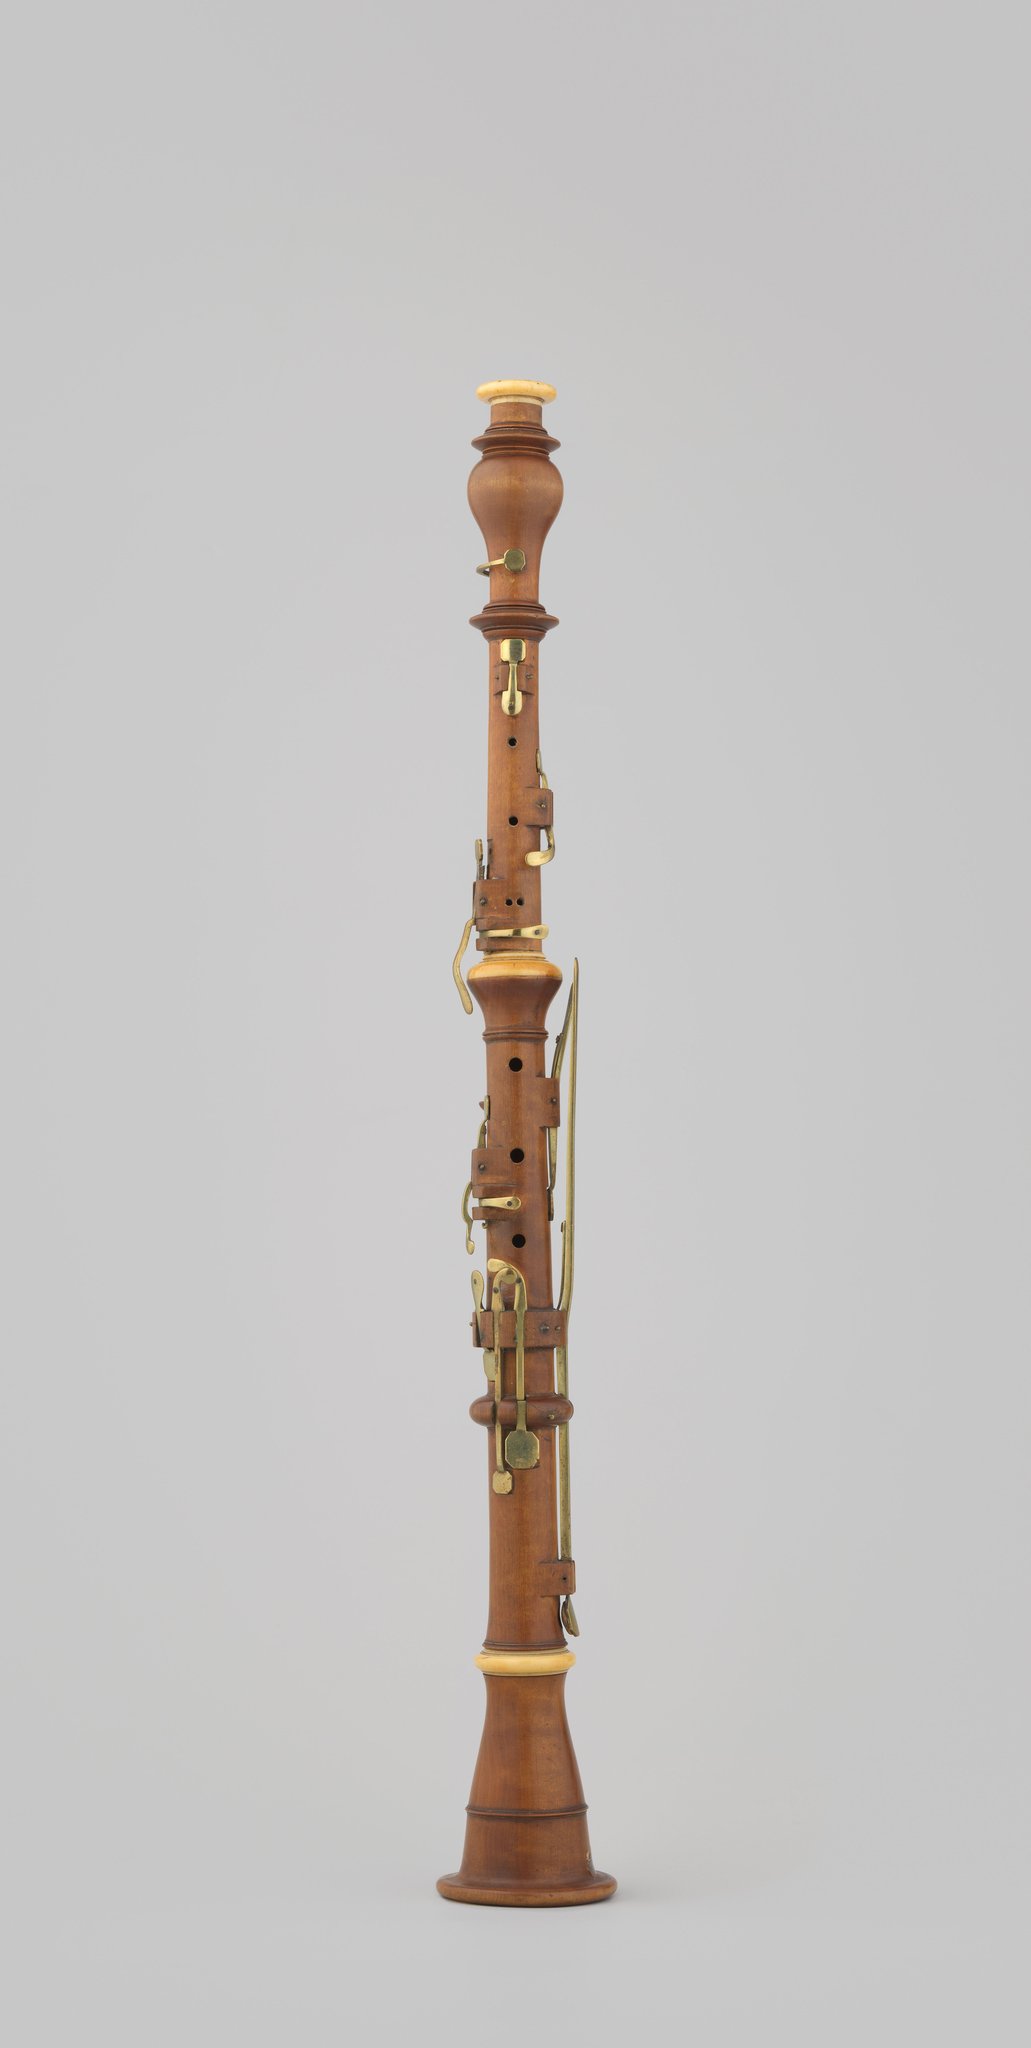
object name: wind instrument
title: Oboe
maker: Anonymous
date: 1830-1840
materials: wood, brass, ivory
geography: germany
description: Hobo van palmhout, in de Duitse traditie, met een korte Weense beker. De hobo heeft twaalf achthoekige messing kleppen en drie ivoren ringen. De bouw vertoont overeenkomsten met Heckel, de kleppen vertonen overeenkomsten met Schott (met uitzondering van het d-es klepje).